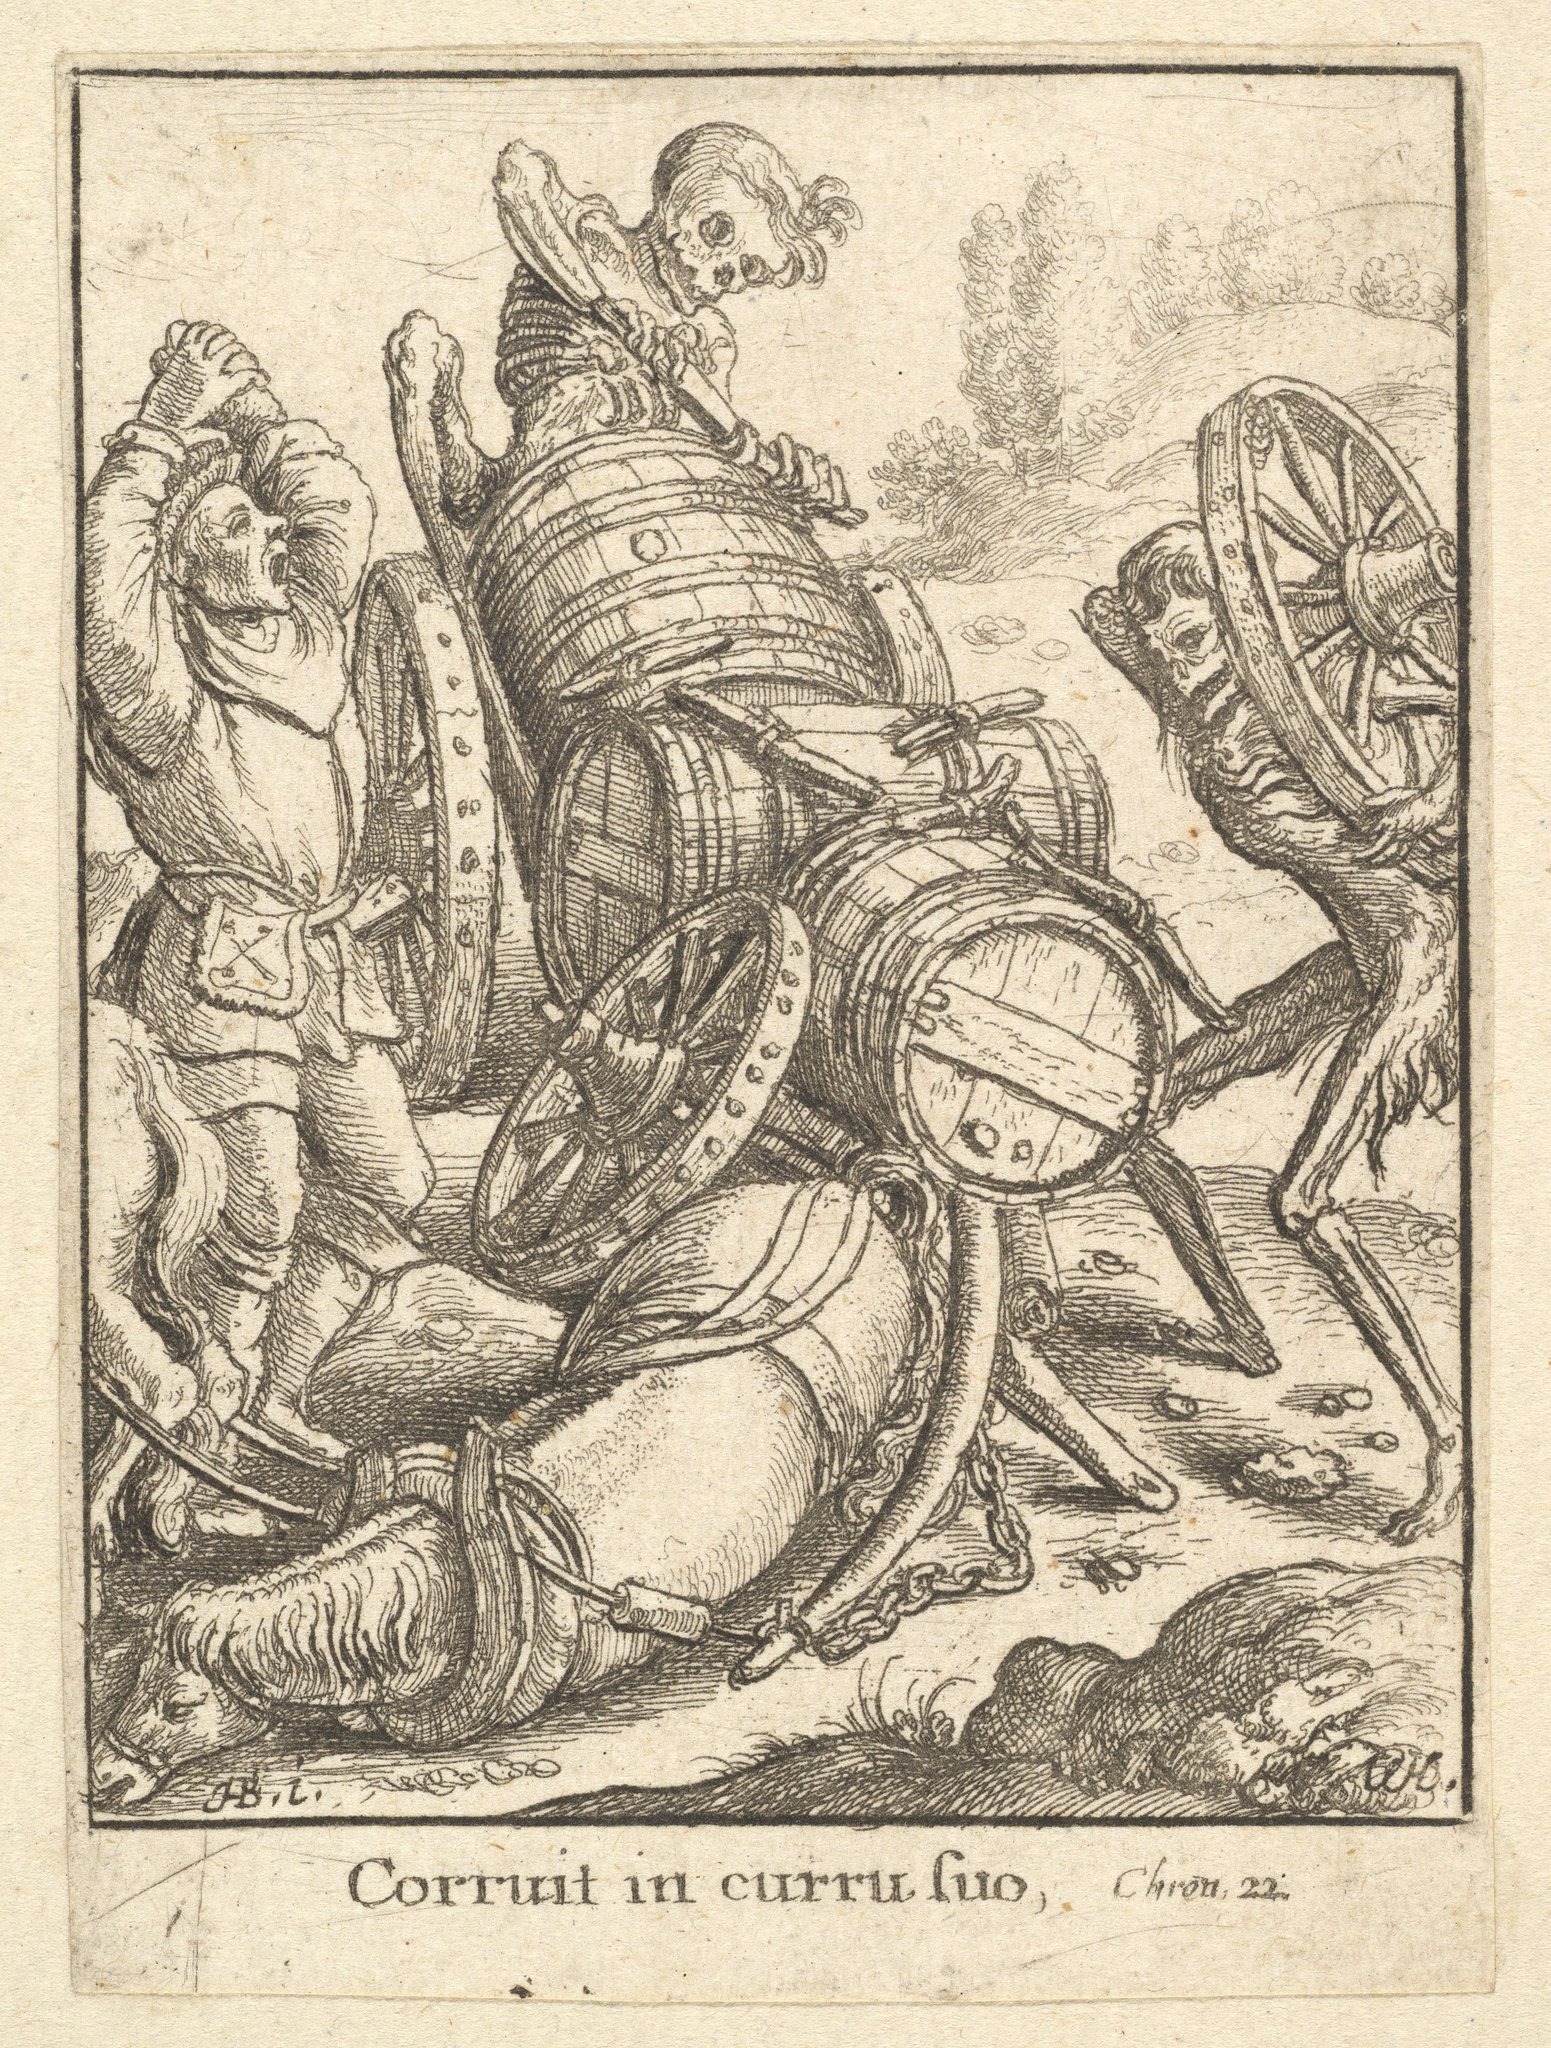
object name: print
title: Waggoner, from the Dance of Death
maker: wenceslaus hollar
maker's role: artist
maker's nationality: bohemian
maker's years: 1607-1677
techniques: etching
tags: skeletons,men,horses